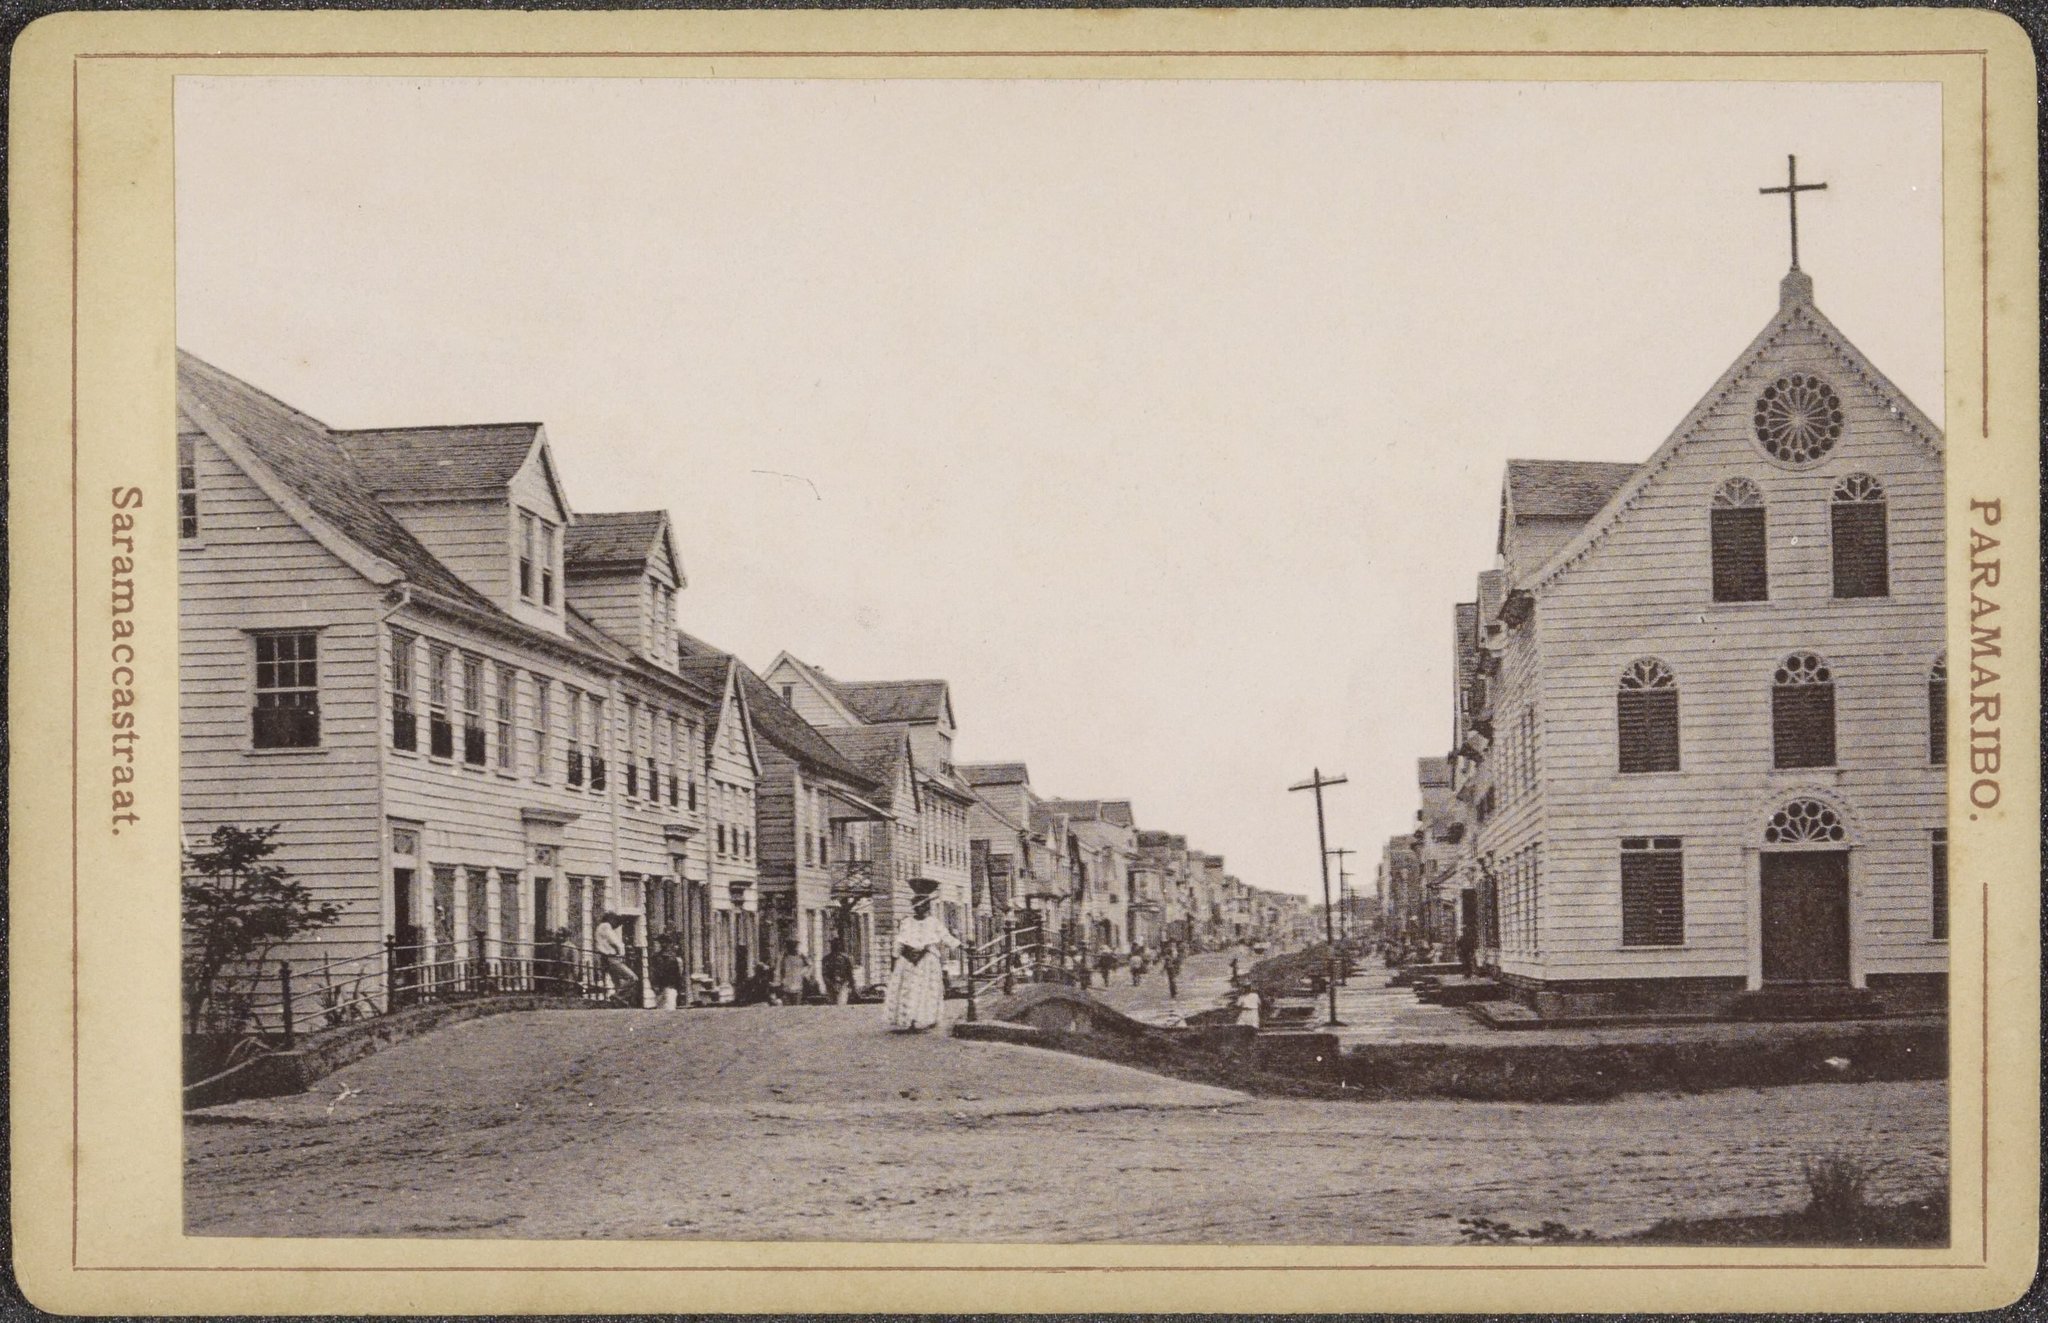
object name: cabinet photograph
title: Paramaribo. Saramaccastraat.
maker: eugen klein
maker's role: fotograaf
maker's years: 1869-1927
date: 1900-1927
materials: cardboard, paper, ink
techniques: photograph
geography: paramaribo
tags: church (exterior), travelling; tourism, bridge, prospect of city, town panorama, silhouette of city, street (+ city(-scape) with figures, staffage), suriname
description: Onderdeel van Fotoalbum met bezienswaardigheden in Paramaribo.